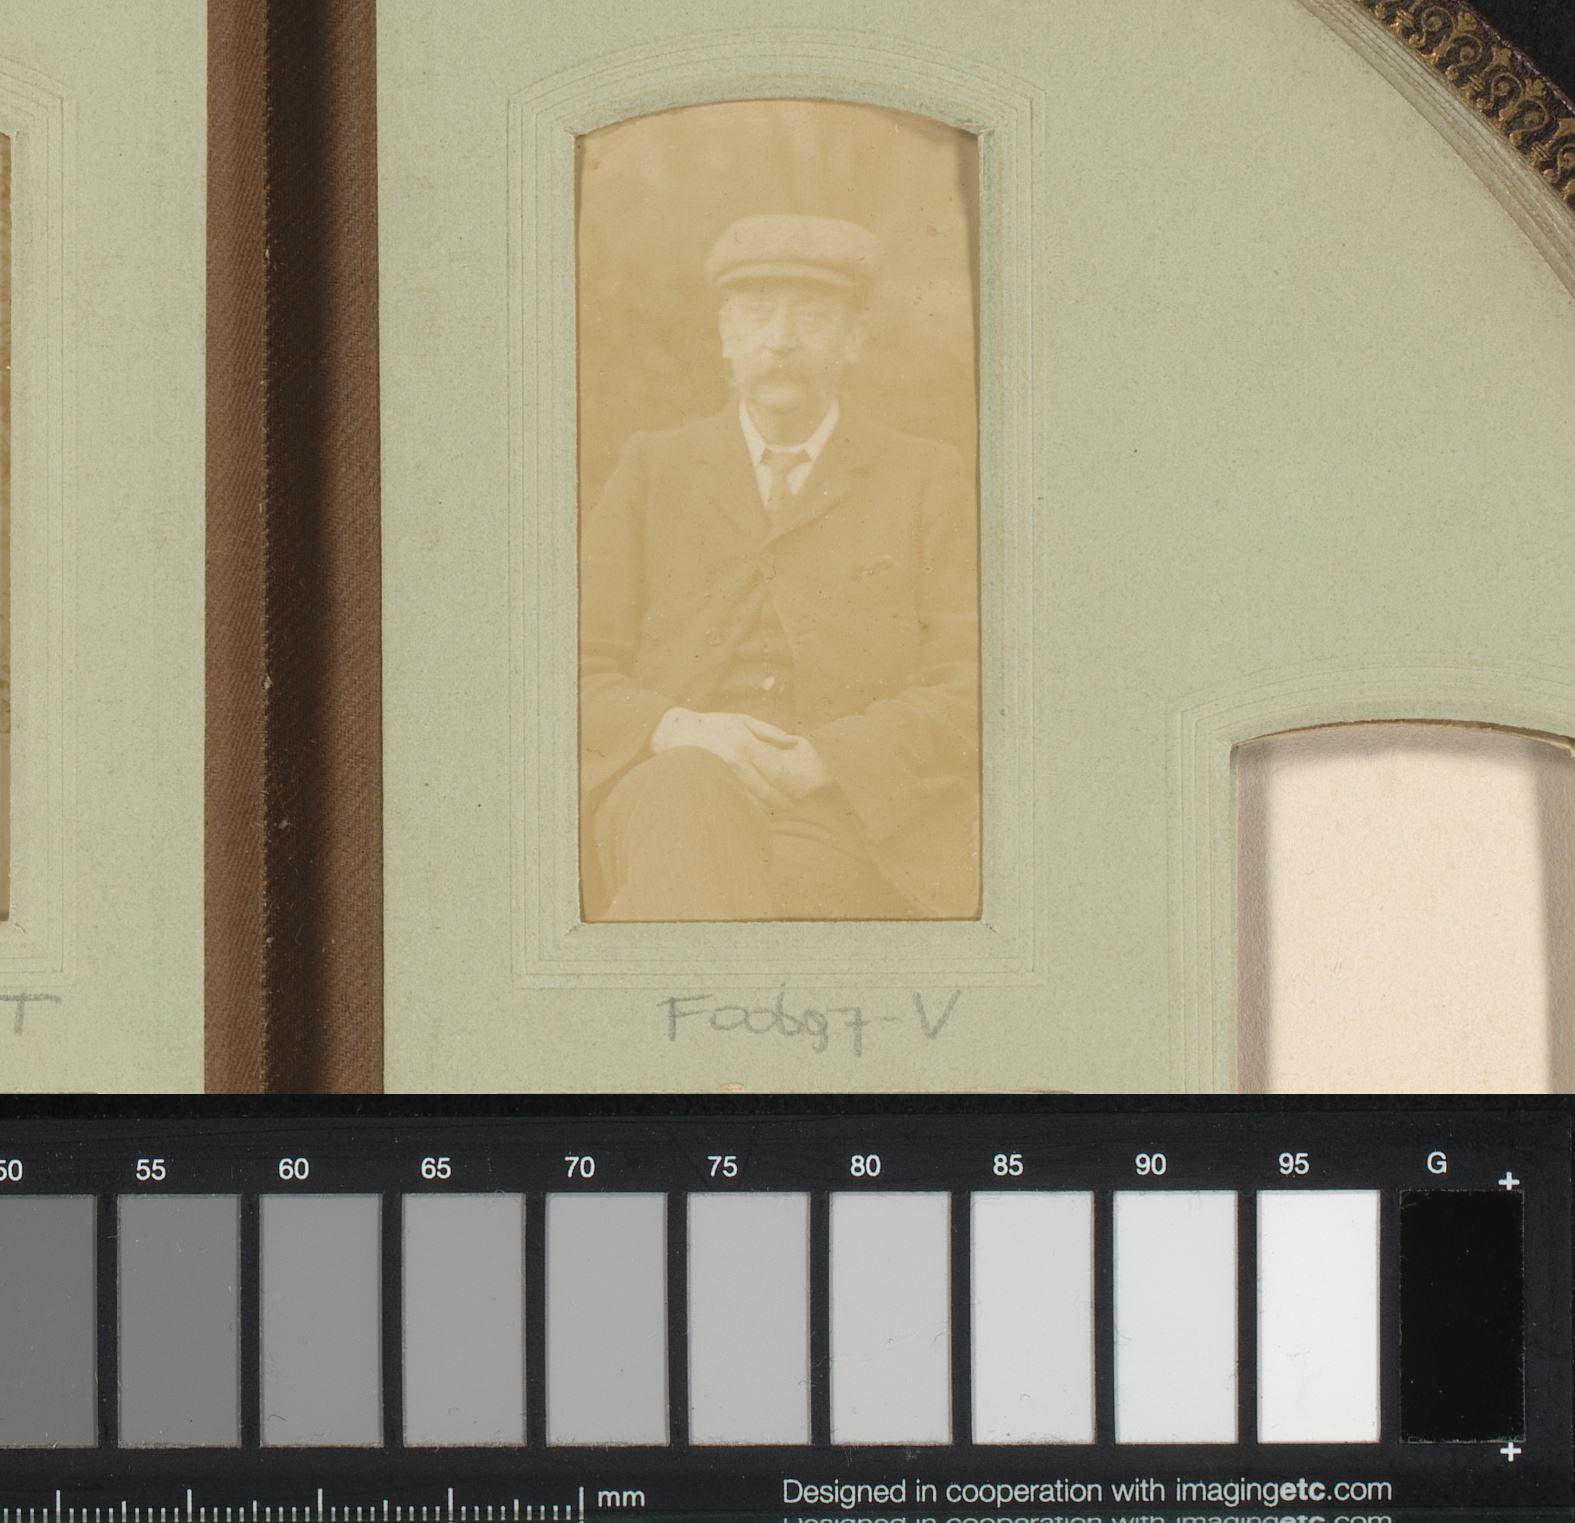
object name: album leaf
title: Portret van een man met pet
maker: Anonymous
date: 1890-1915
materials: photographic support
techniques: gelatin silver print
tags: moustache, adult man, historical persons, head-gear: cap